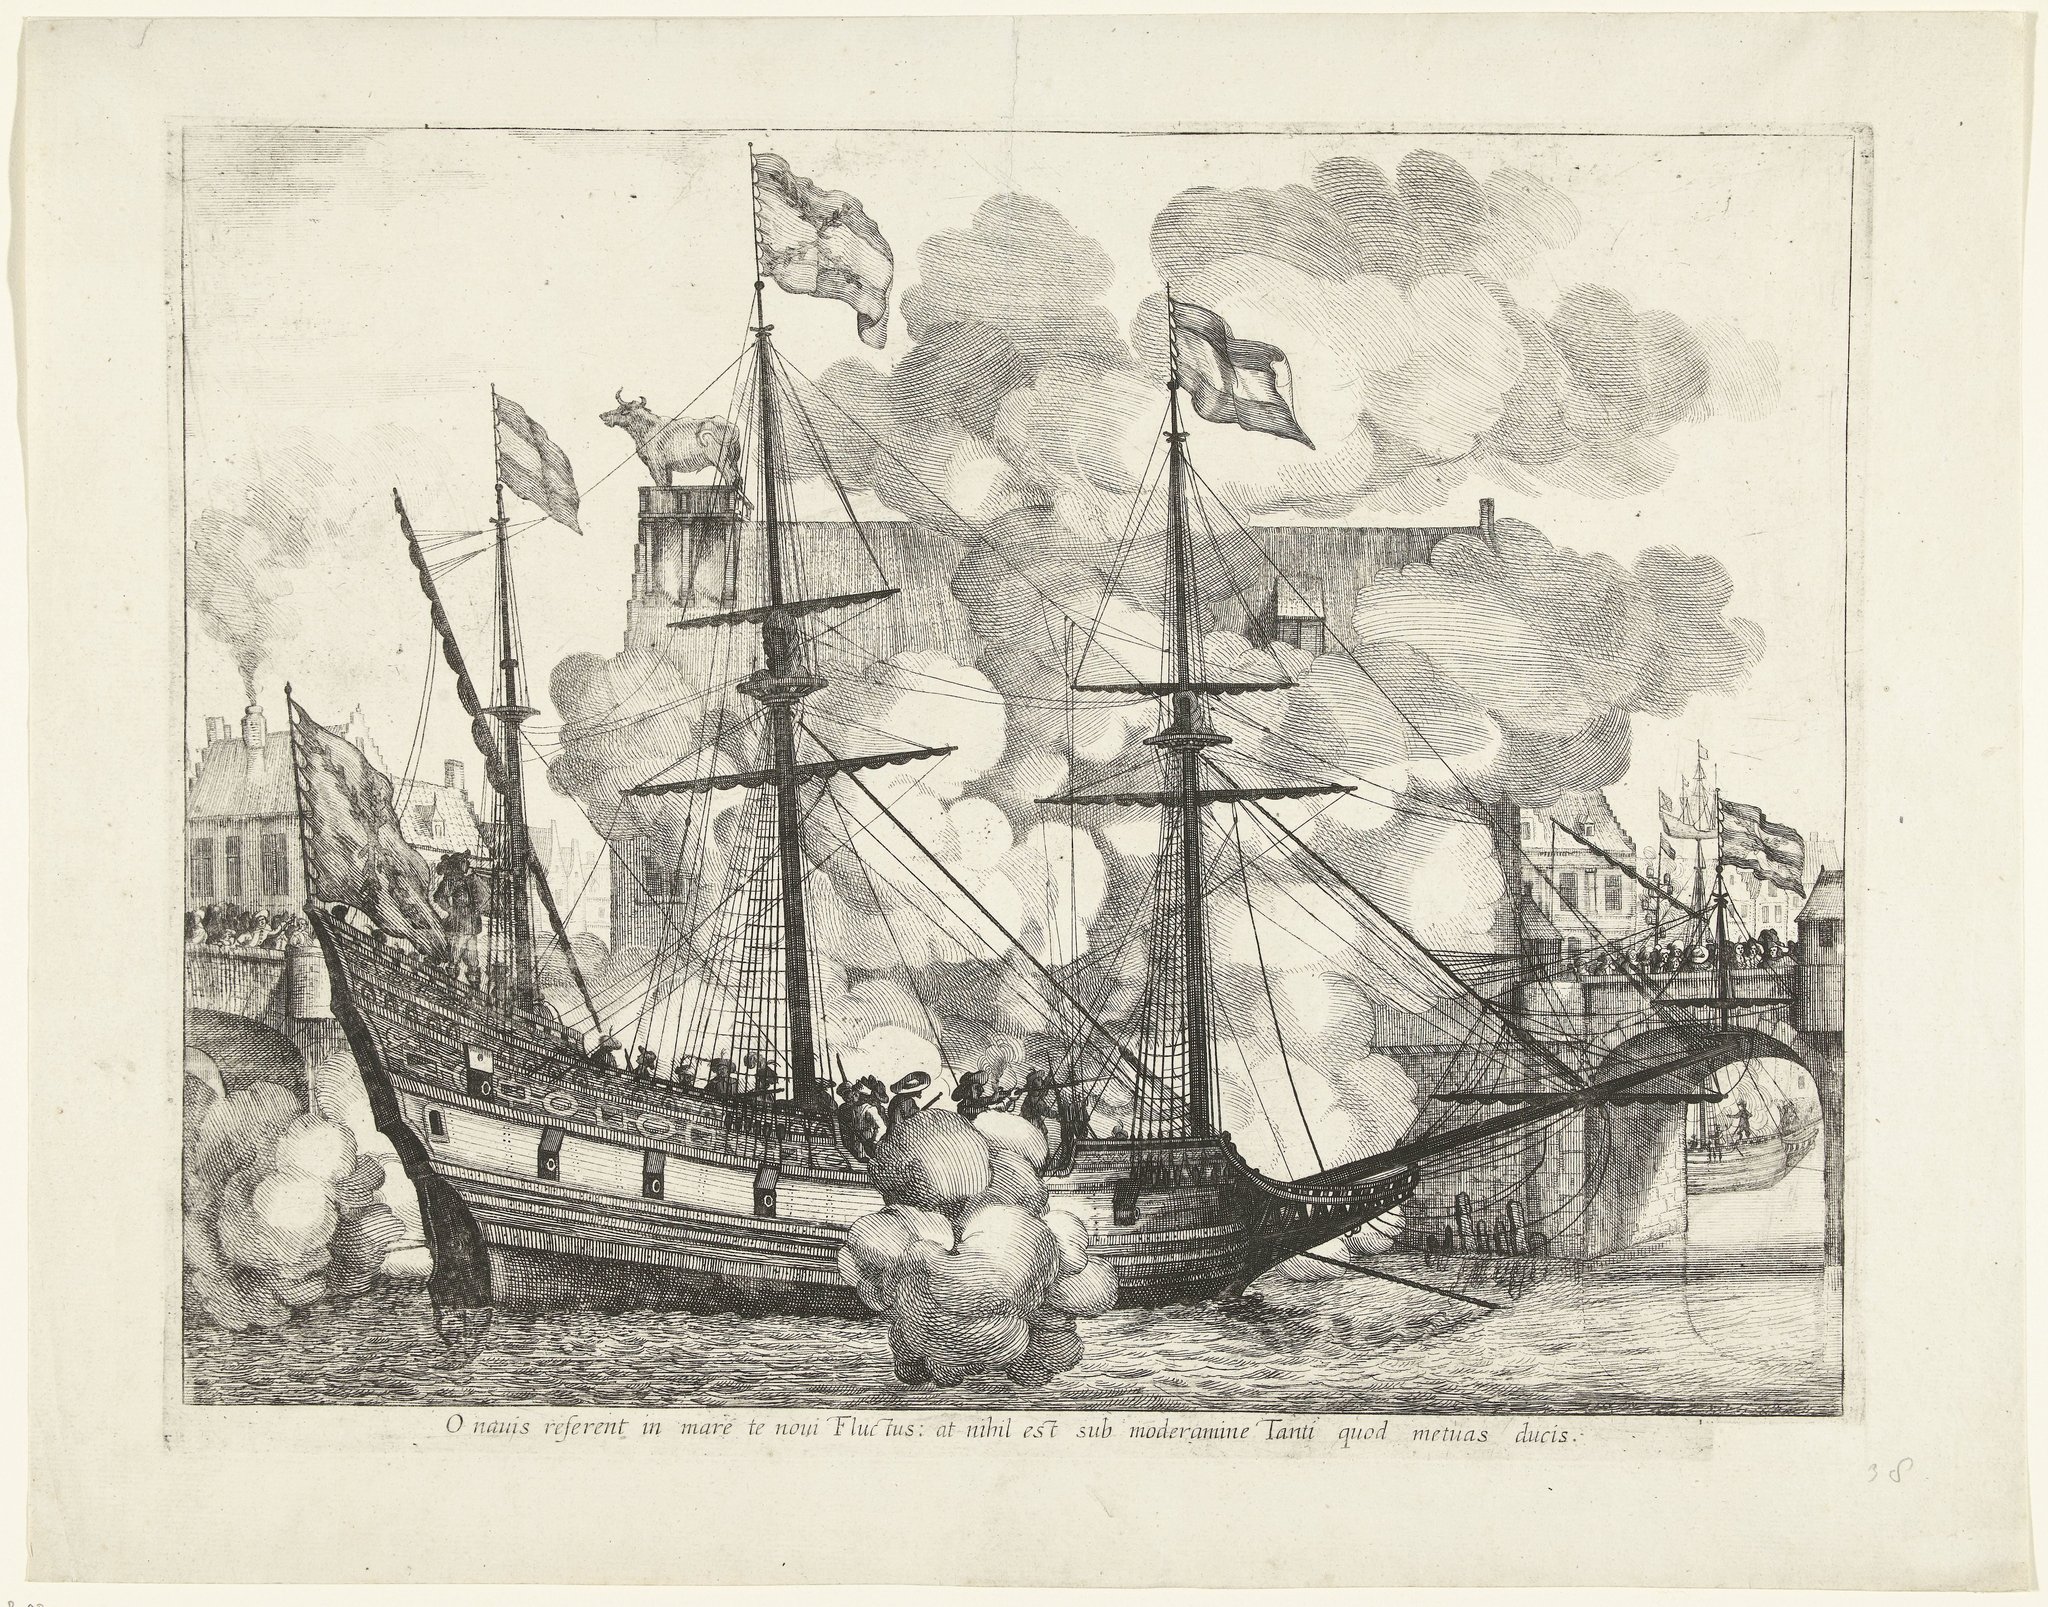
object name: print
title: O navus referent in mare te novi Fluctus: at nihil est sub moderamine Tanti quod metuas ducis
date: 1635-1636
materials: paper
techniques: engraving, etching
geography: southern netherlands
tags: brussels, landvoogd der zuidelijke nederlanden ferdinand van oostenrijk, ships (in general) (+ propulsion of vehicle, ship, etc. by wind), triumphal entry and public reception, pageant, 'entrée solennelle', 'joyeuse entrée', ghent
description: Zeilschip die de veiligheid ter zee symboliseert aan een kade te Gent. Op de kades veel toeschouwers. Blad nr. 38 in een geheel van 42 platen die de uitgave van de beschrijving van de intocht van de Kardinaal Infant Ferdinand van Oostenrijk te Gent op 28 januari 1635 als de nieuwe landvoogd voor de Spaanse Nederlanden illustreren.